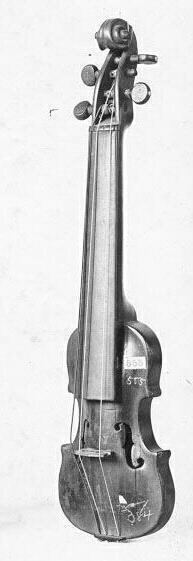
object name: pochette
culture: italian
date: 1701-1800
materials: wood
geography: italy